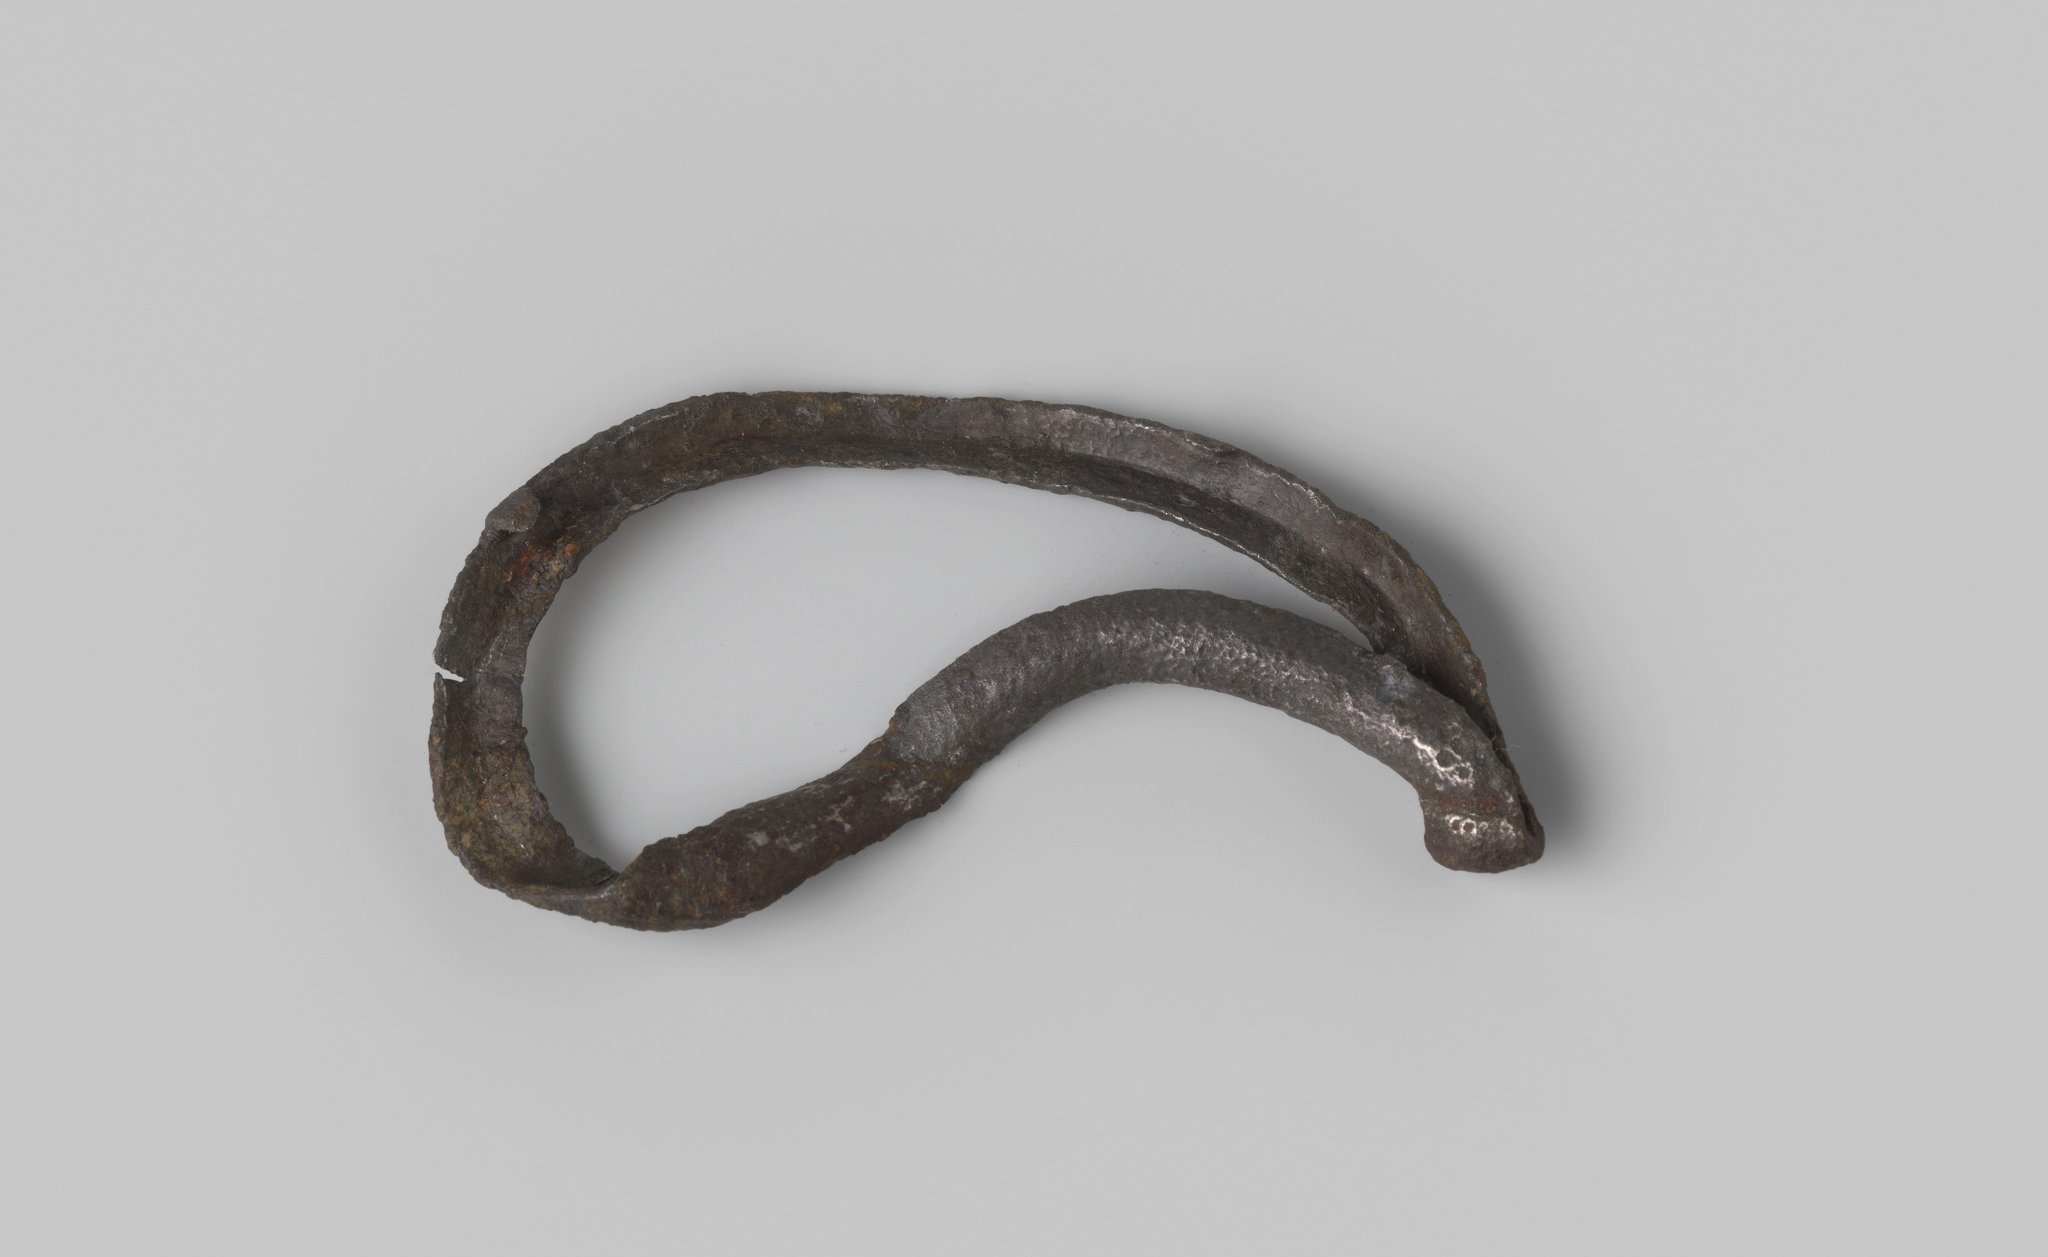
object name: setting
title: Montuur van een verpakking uit het wrak van de Oost-Indiëvaarder Hollandia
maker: Anonymous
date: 1700-1743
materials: tin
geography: netherlands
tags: verenigde oostindische compagnie, hollandia (schip), annet